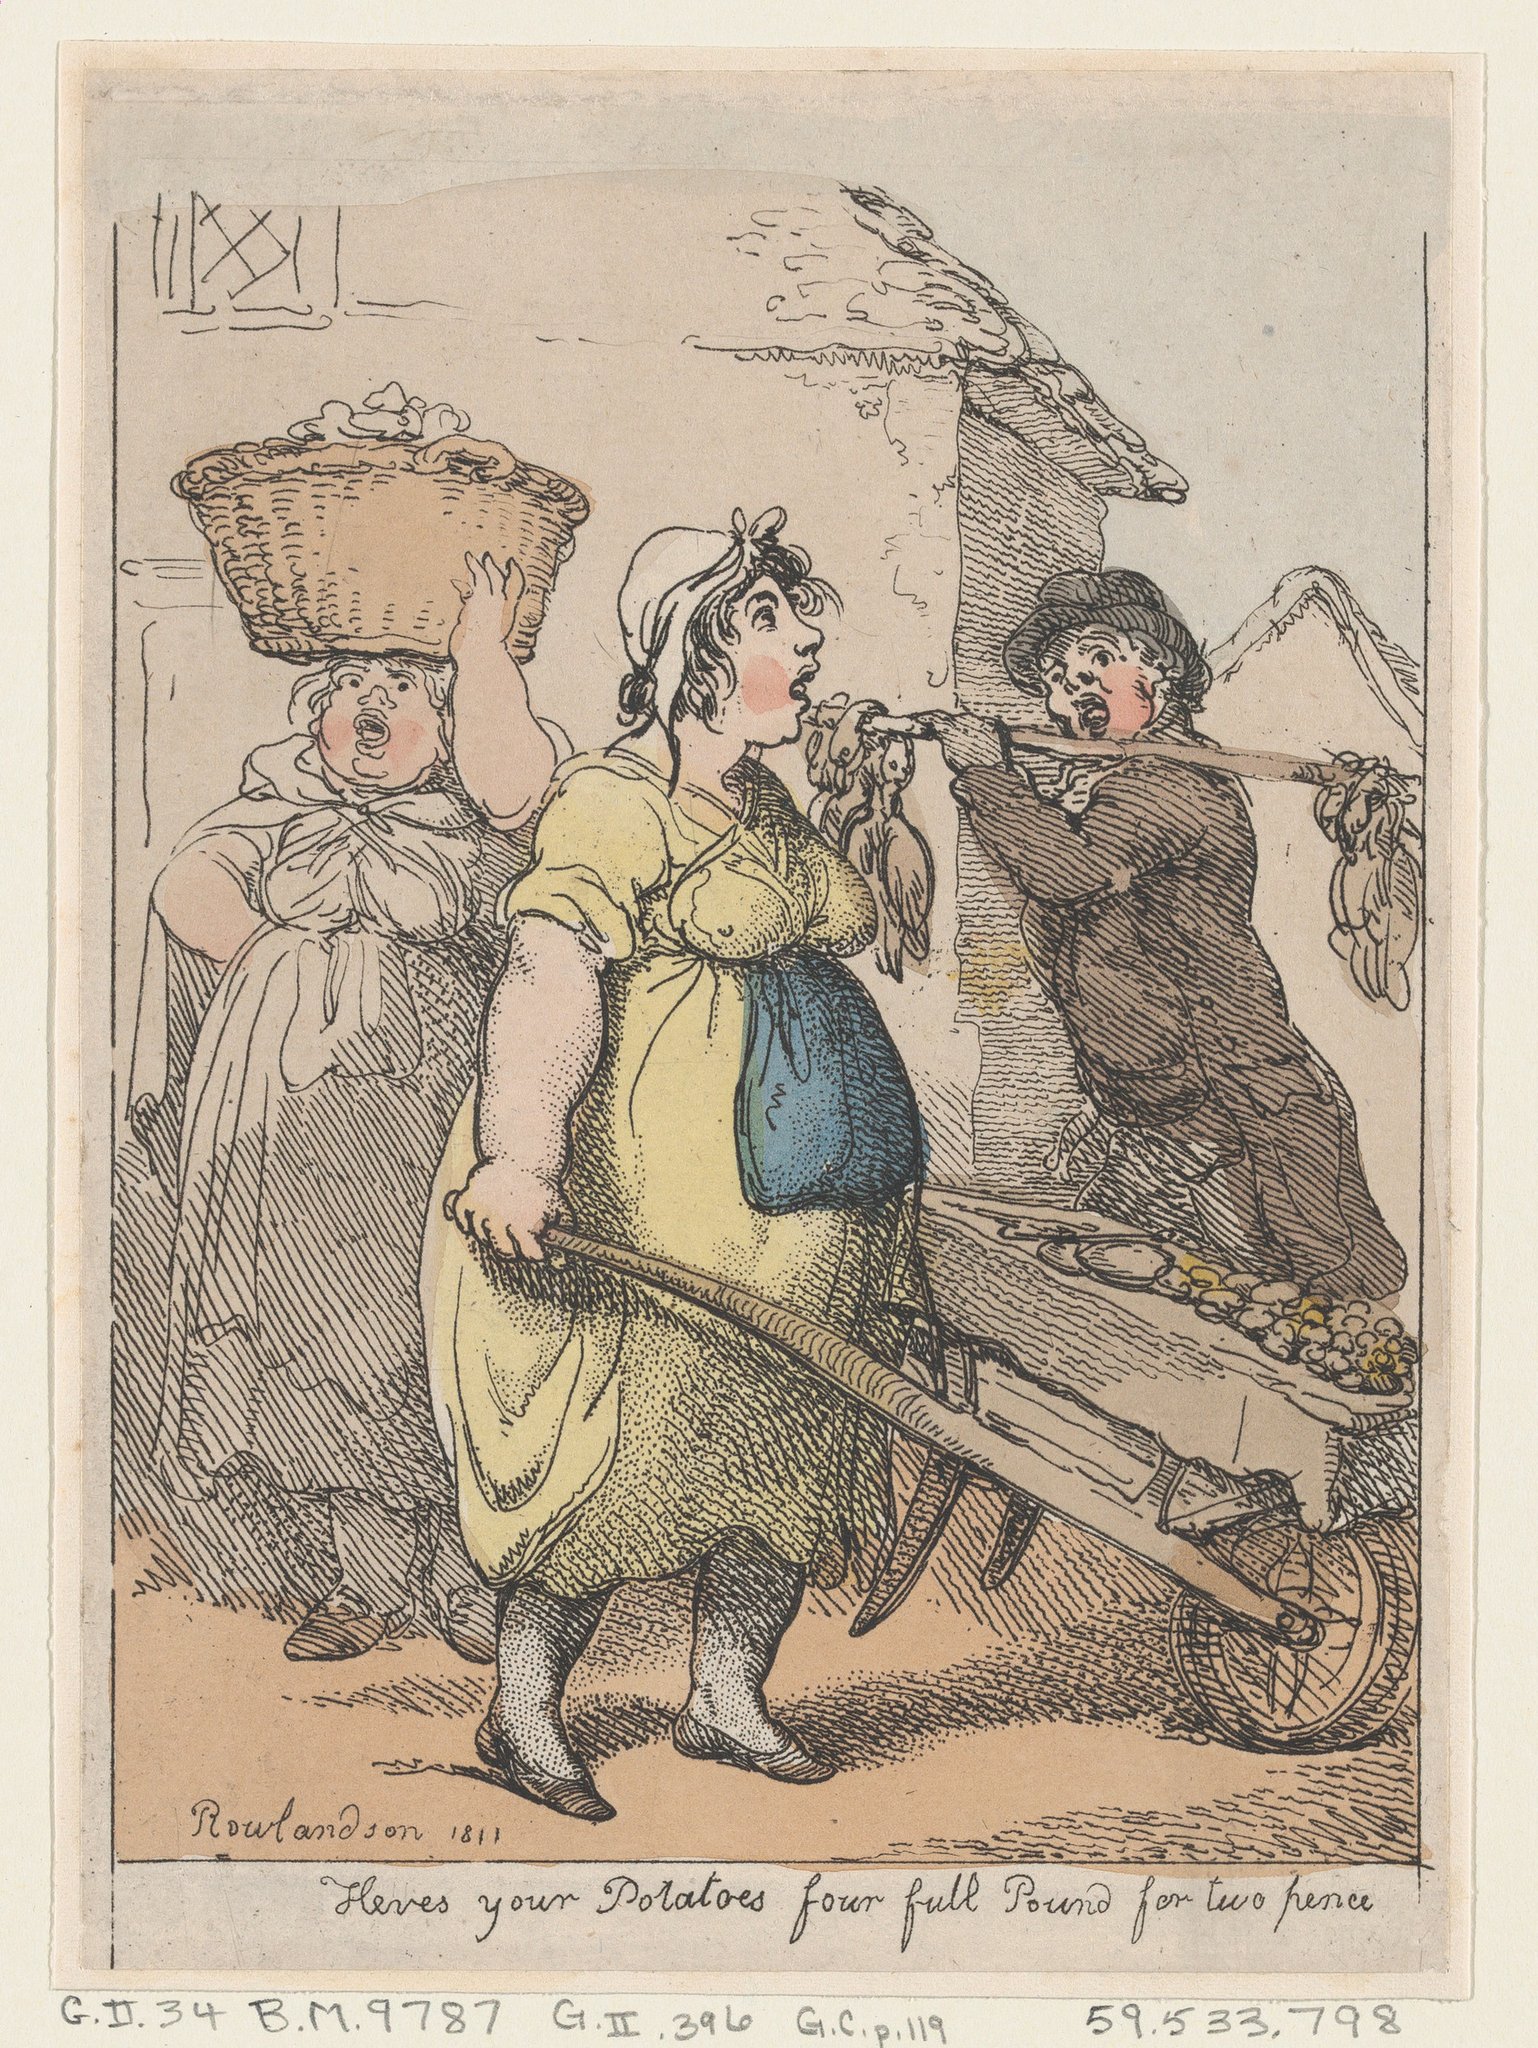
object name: print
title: Here's Your Potatoes, Four Full Pounds for Two Pence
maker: thomas rowlandson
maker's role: artist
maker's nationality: british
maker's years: 1757-1827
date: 1811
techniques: etching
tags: men,women